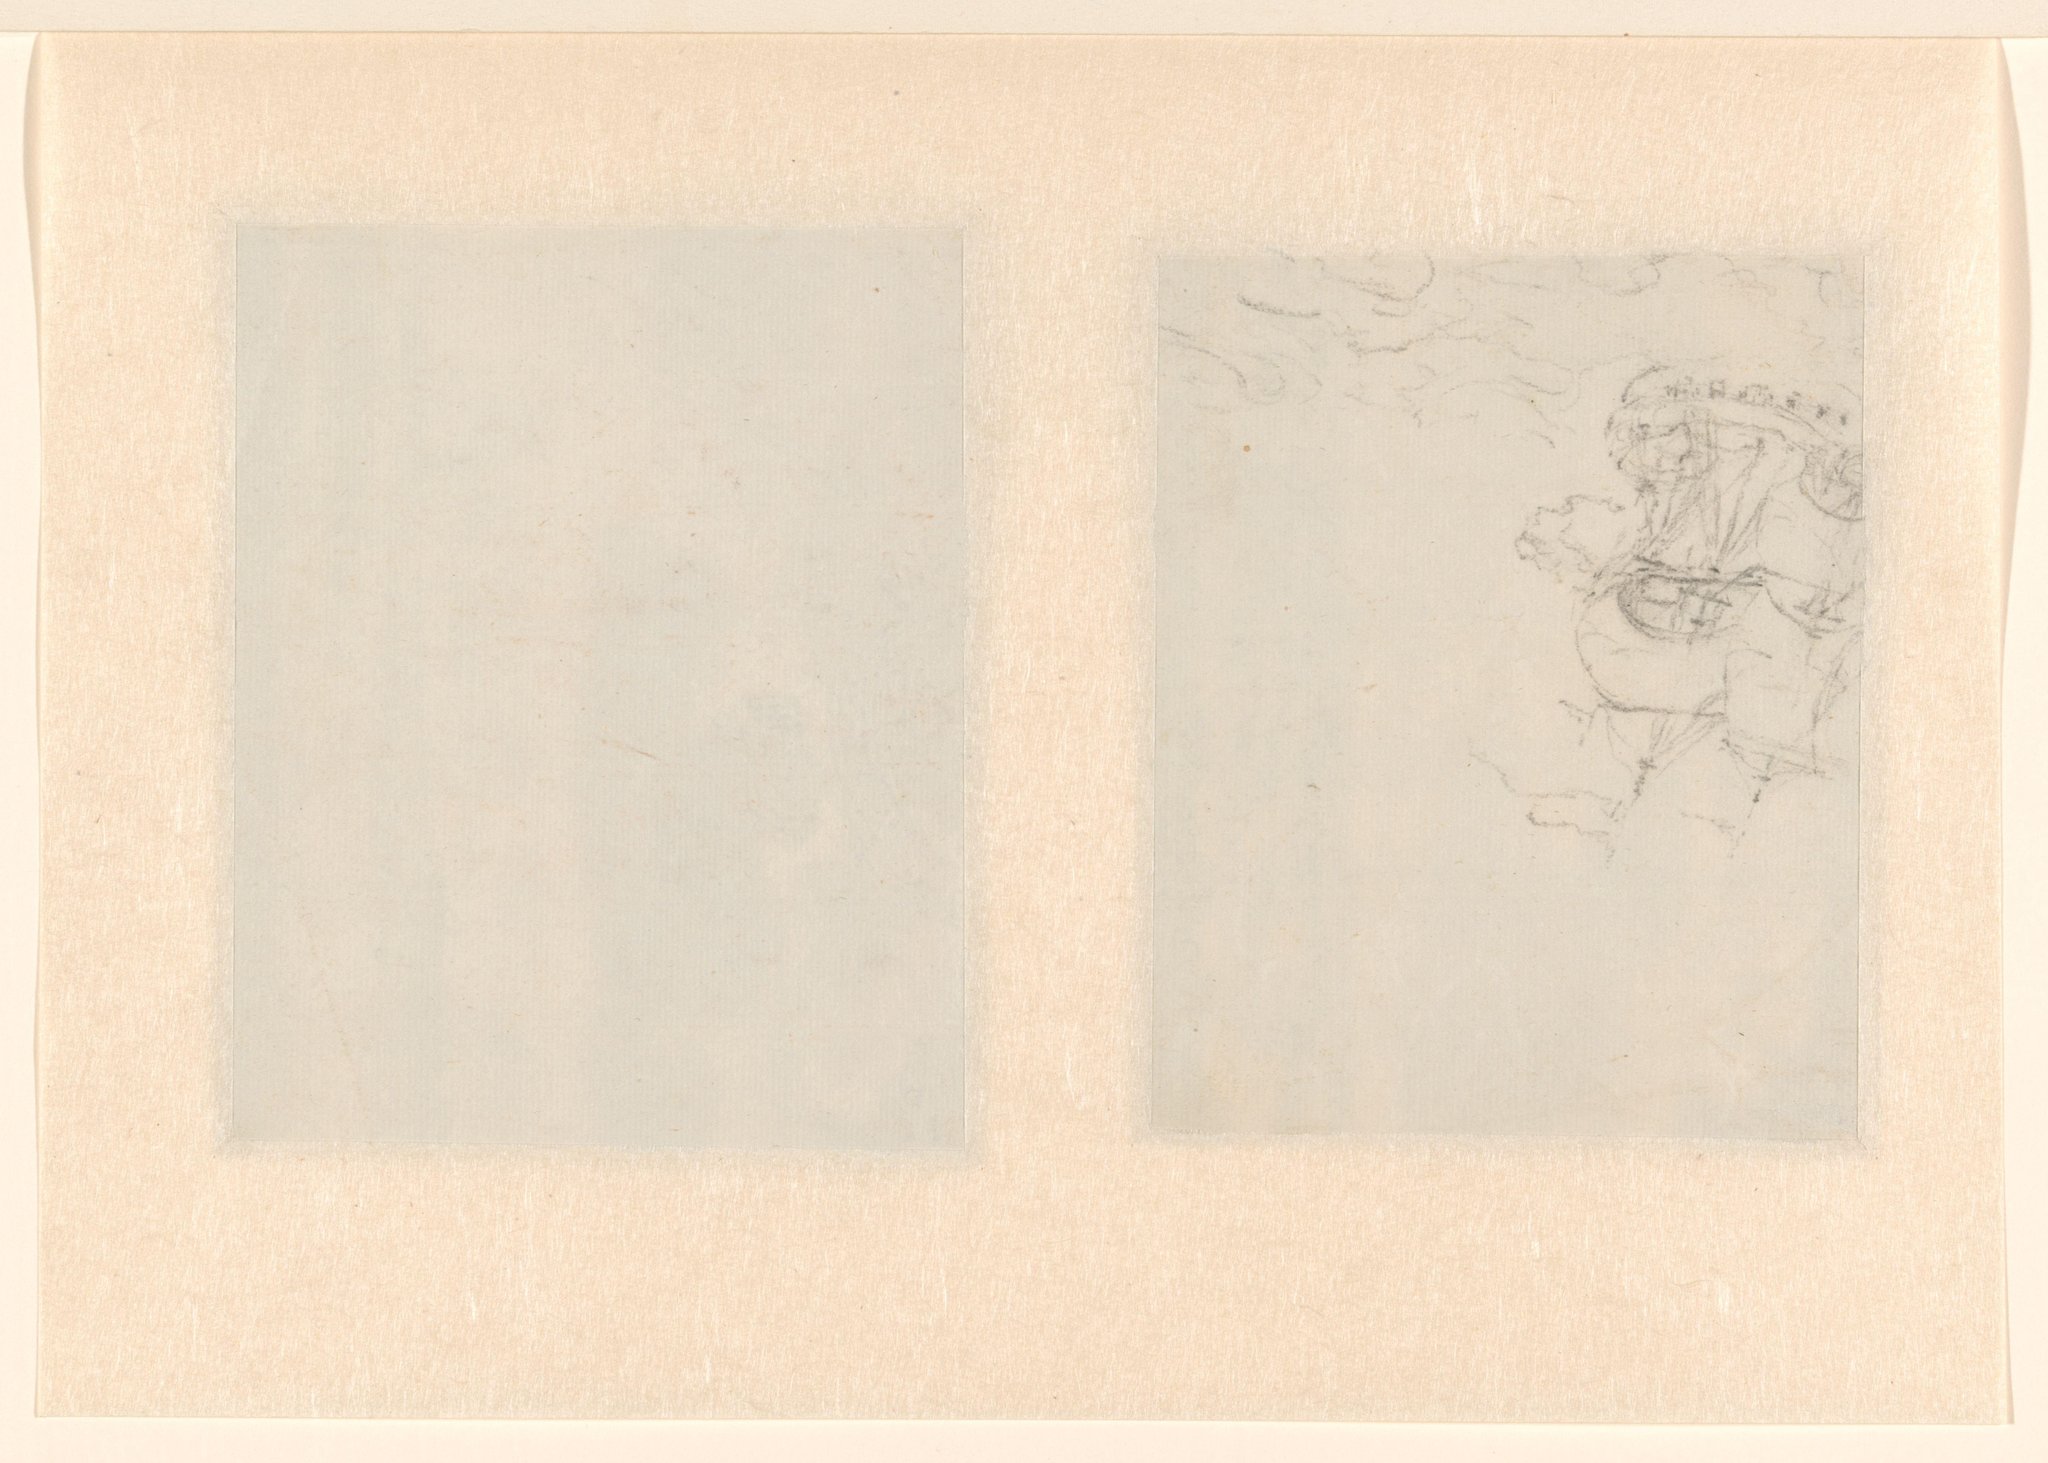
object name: drawing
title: Zeilschip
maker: pieter idserts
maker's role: draughtsman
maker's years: 1698-1781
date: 1708-1781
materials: chalk, paper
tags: sailing-ship, sailing-boat